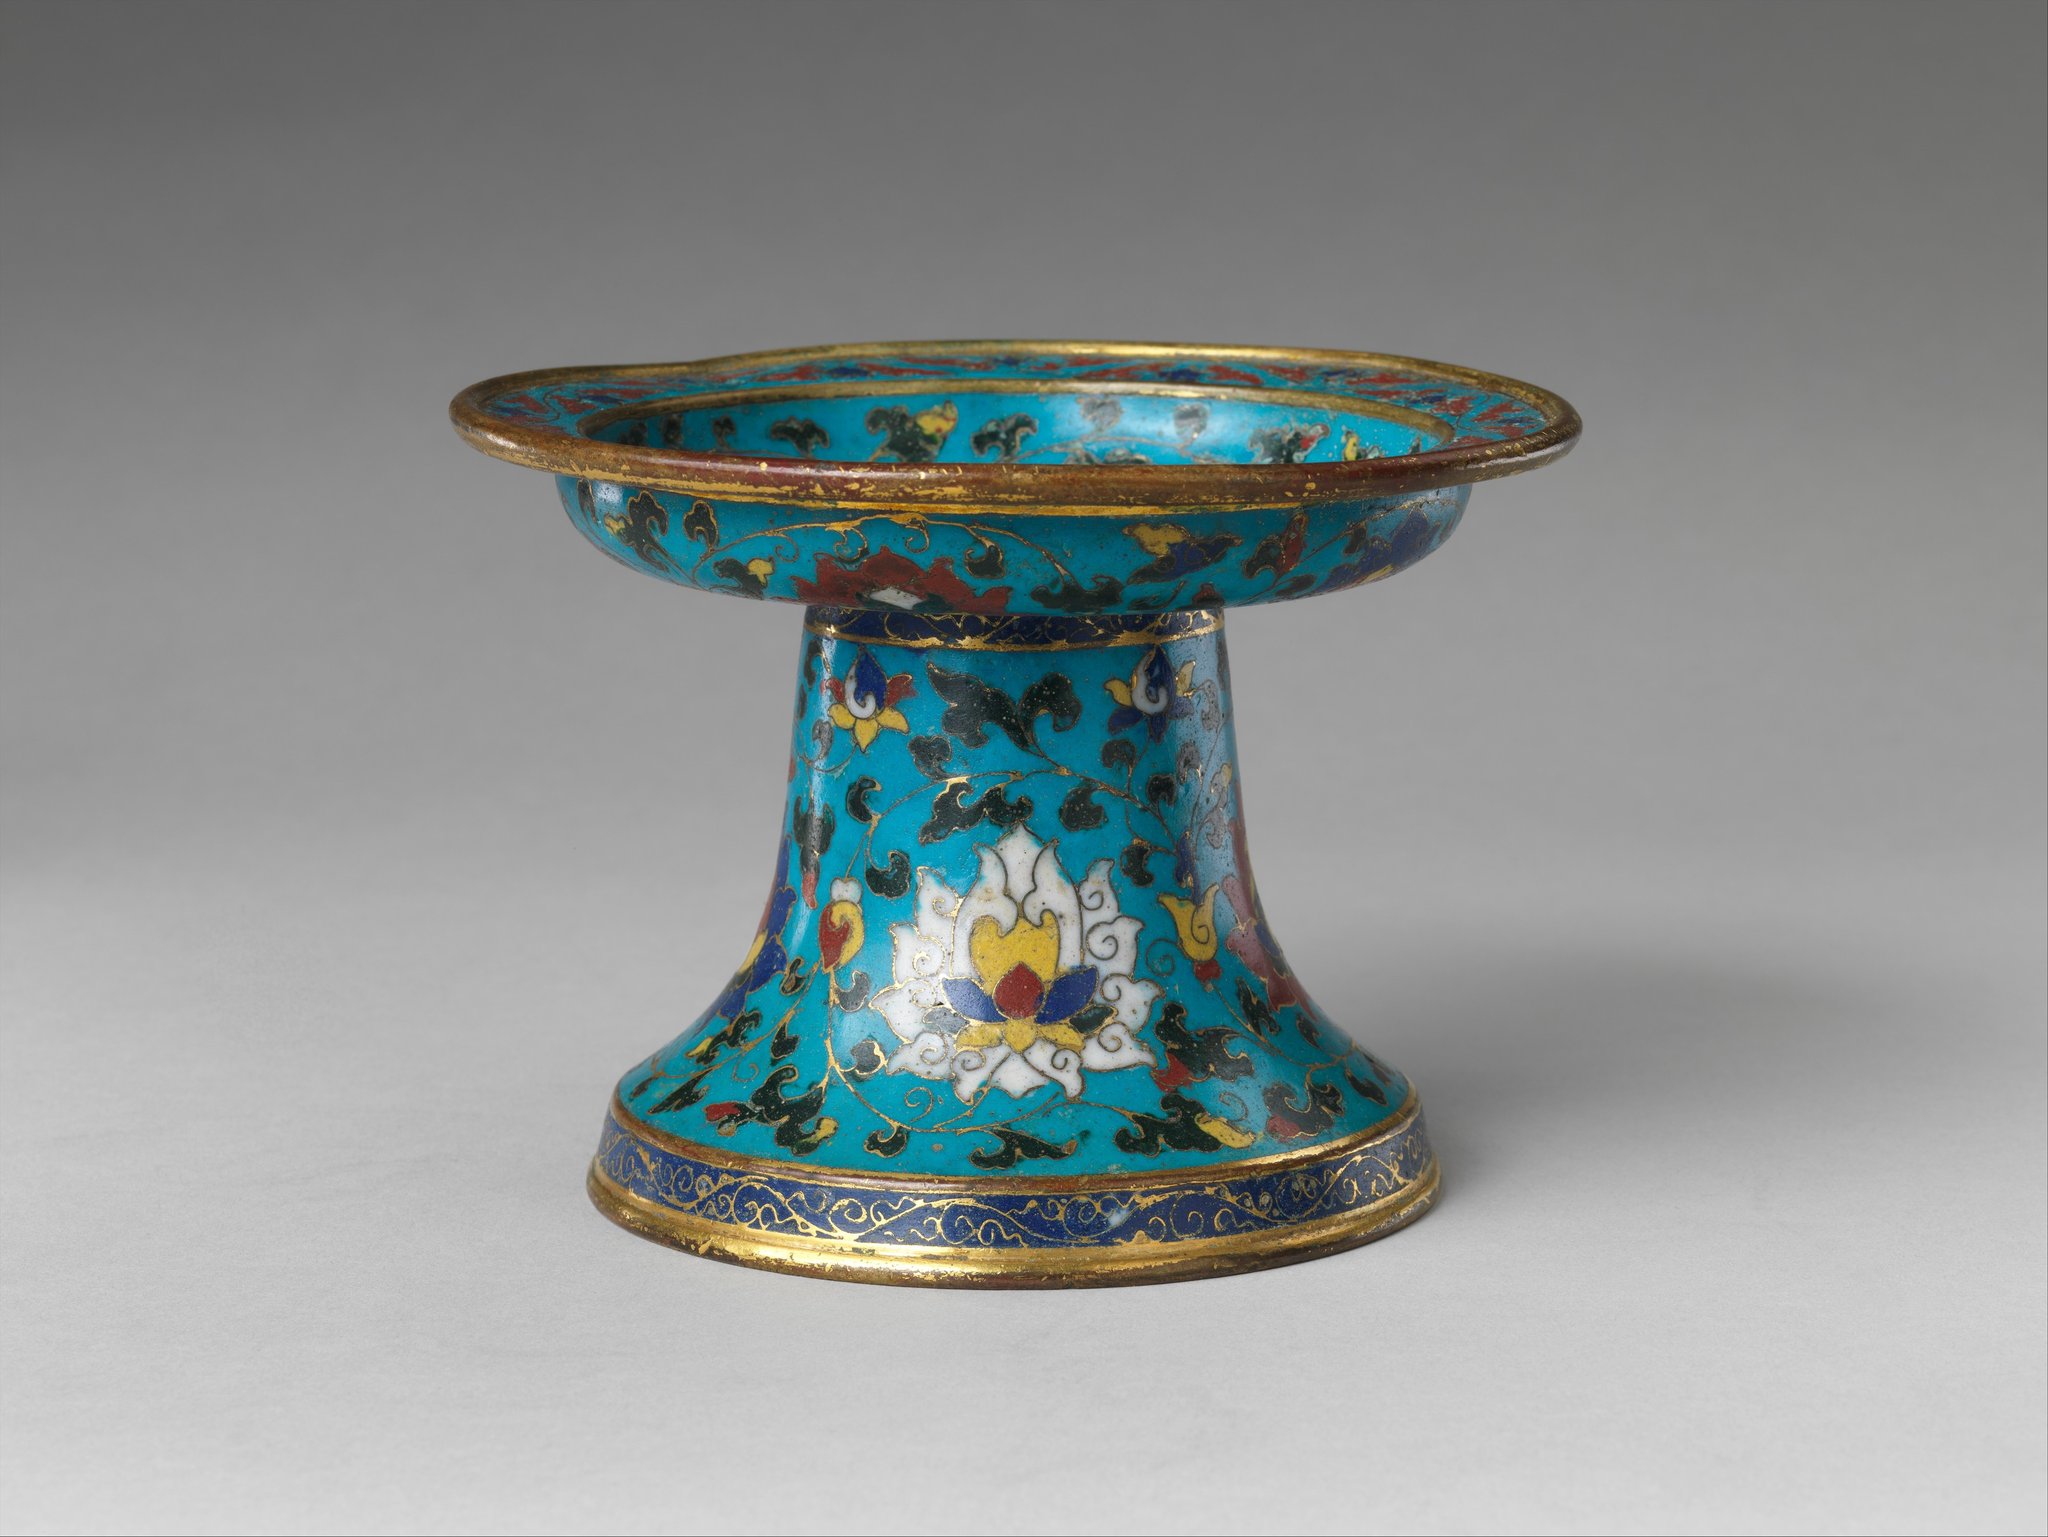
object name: candlestick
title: Candlestick with lotus scrolls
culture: chinese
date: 1367-1433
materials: enamel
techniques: enamel